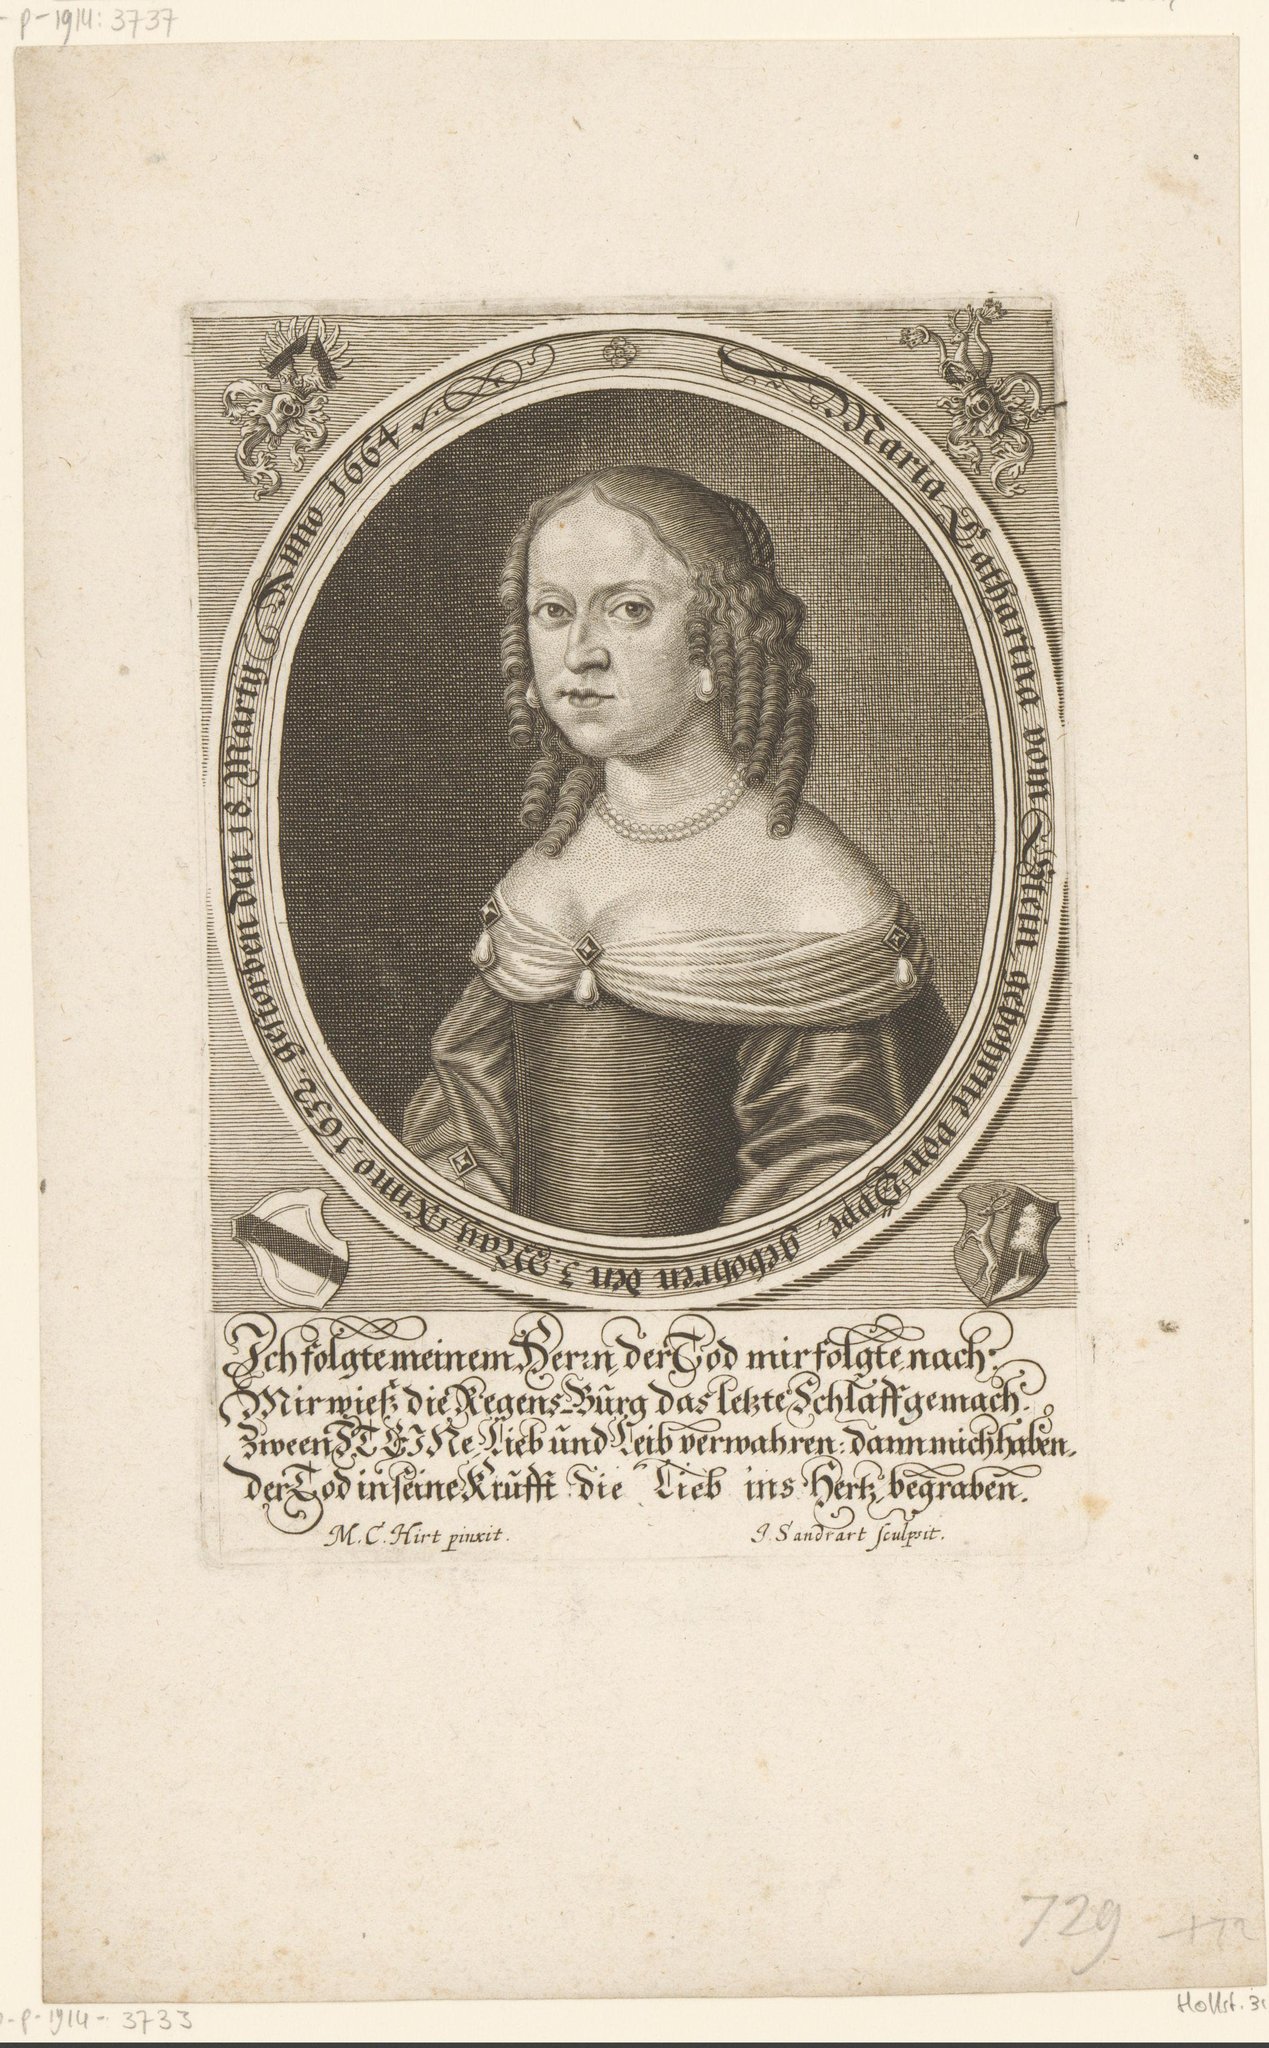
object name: print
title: Portret van Maria Catharina von Stein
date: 1664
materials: paper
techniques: engraving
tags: historical persons - bb - woman, armorial bearing, heraldry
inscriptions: collector's mark: Lugt 2228